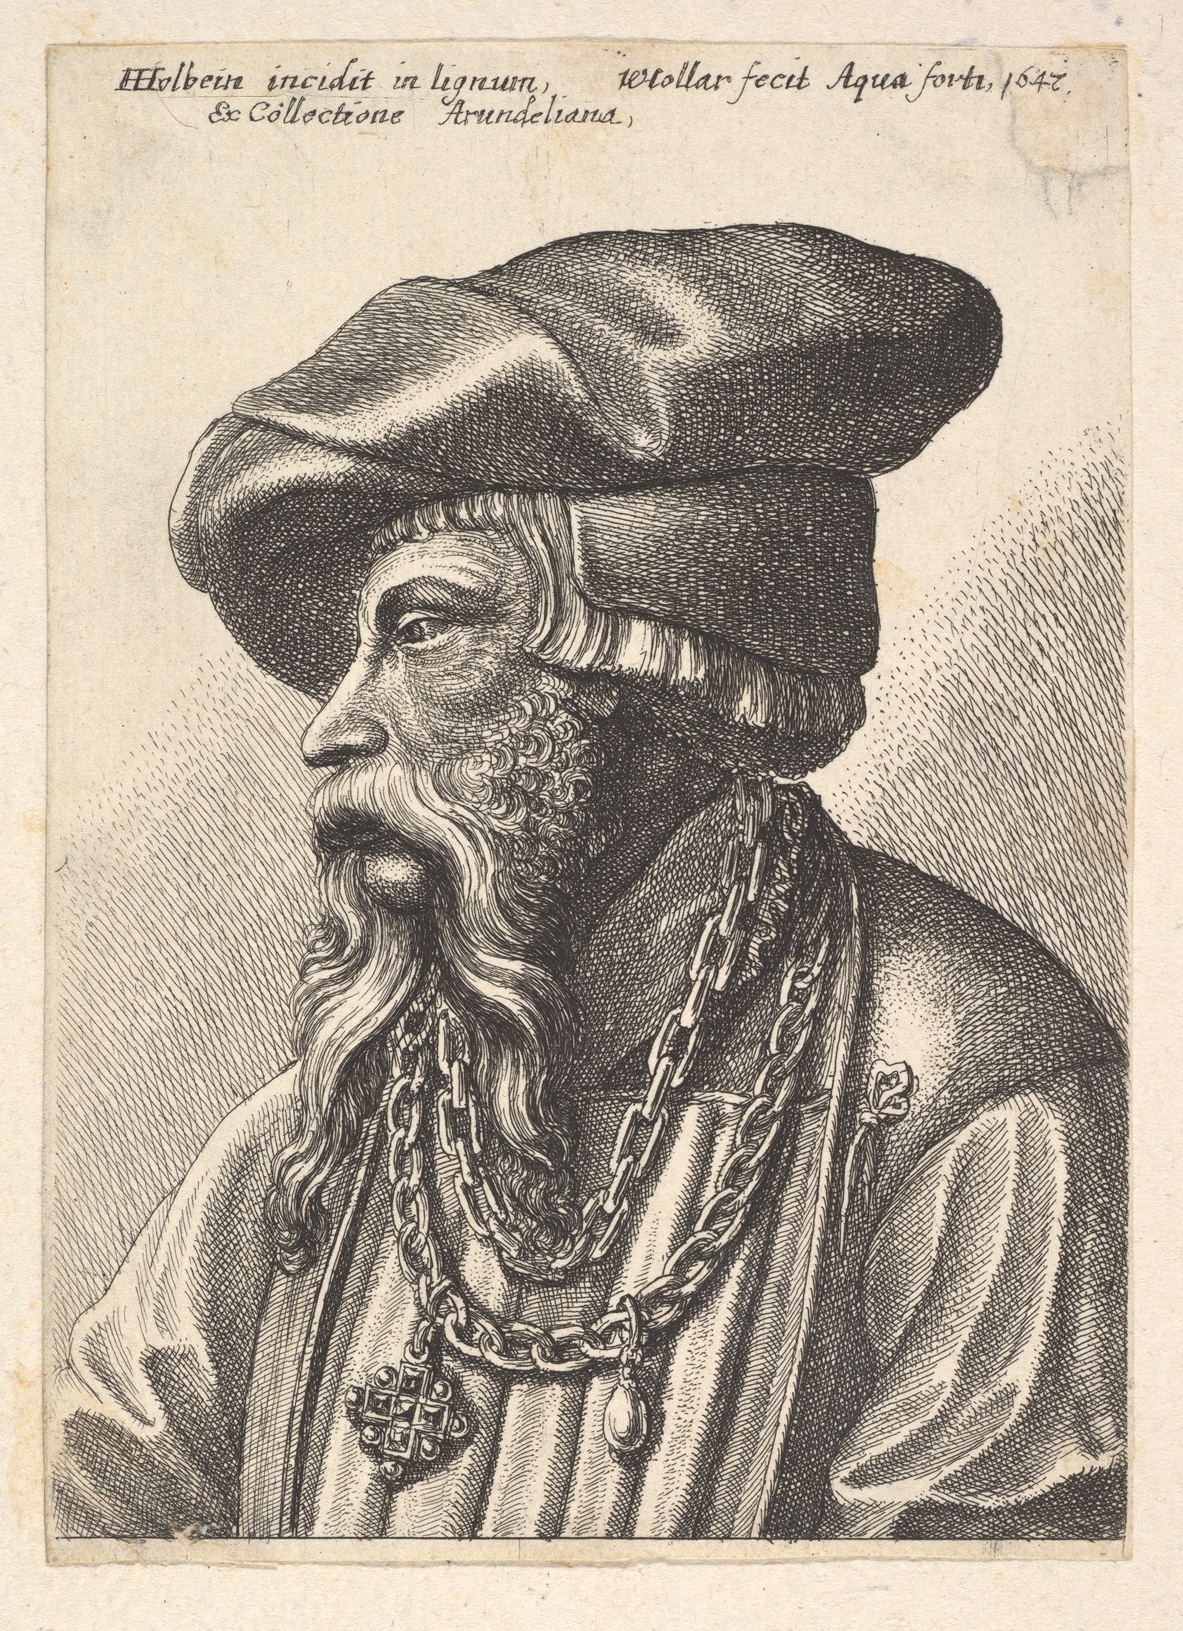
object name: print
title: Bearded man with chain necklace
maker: wenceslaus hollar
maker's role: artist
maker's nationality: bohemian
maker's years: 1607-1677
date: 1647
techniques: cutting, etching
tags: necklaces,men